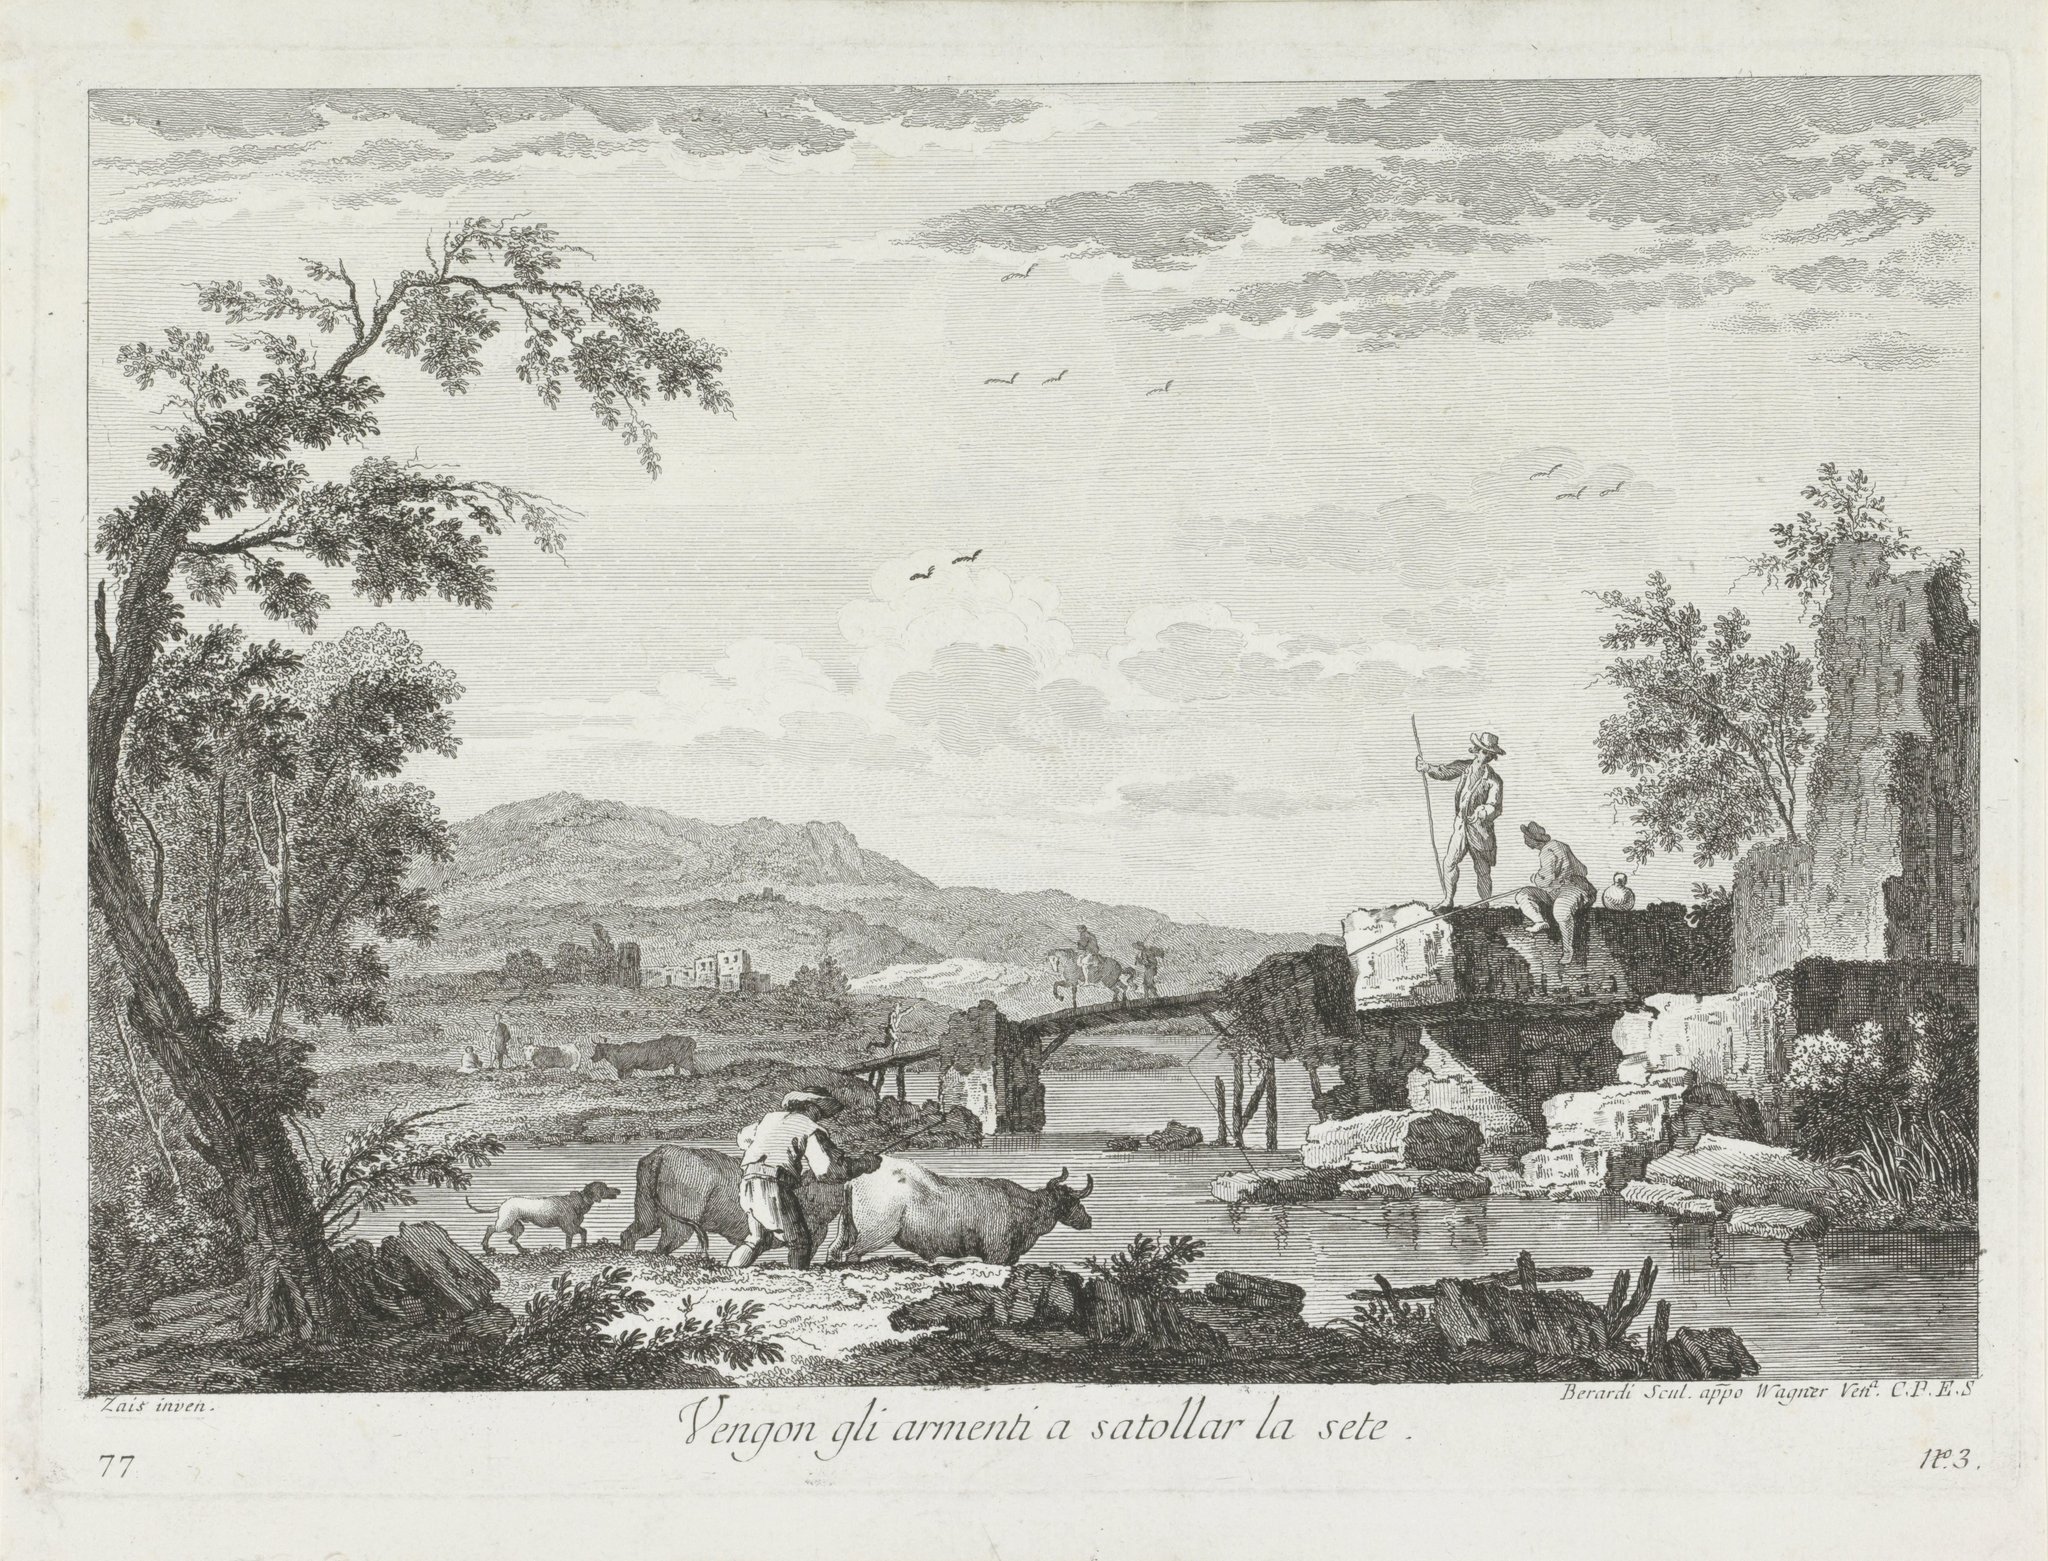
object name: print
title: Landschap met vissers en herder met kudde bij rivier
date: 1738-1767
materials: paper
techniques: etching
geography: italy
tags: crossing a river, landscapes, herding, herdsman, herdswoman, shepherd, shepherdess, cowherd, etc., herd, flock, fisherman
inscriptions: collector's mark: Lugt 2228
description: Een landschap met een herder met zijn ossen bij een rivier. Rechts twee vissers aan de waterkant. Op de achtergrond een ruiter te paard en een figuur te voet op een brug. Genummerd linksonder: 77 en rechtsonder: No. 3.